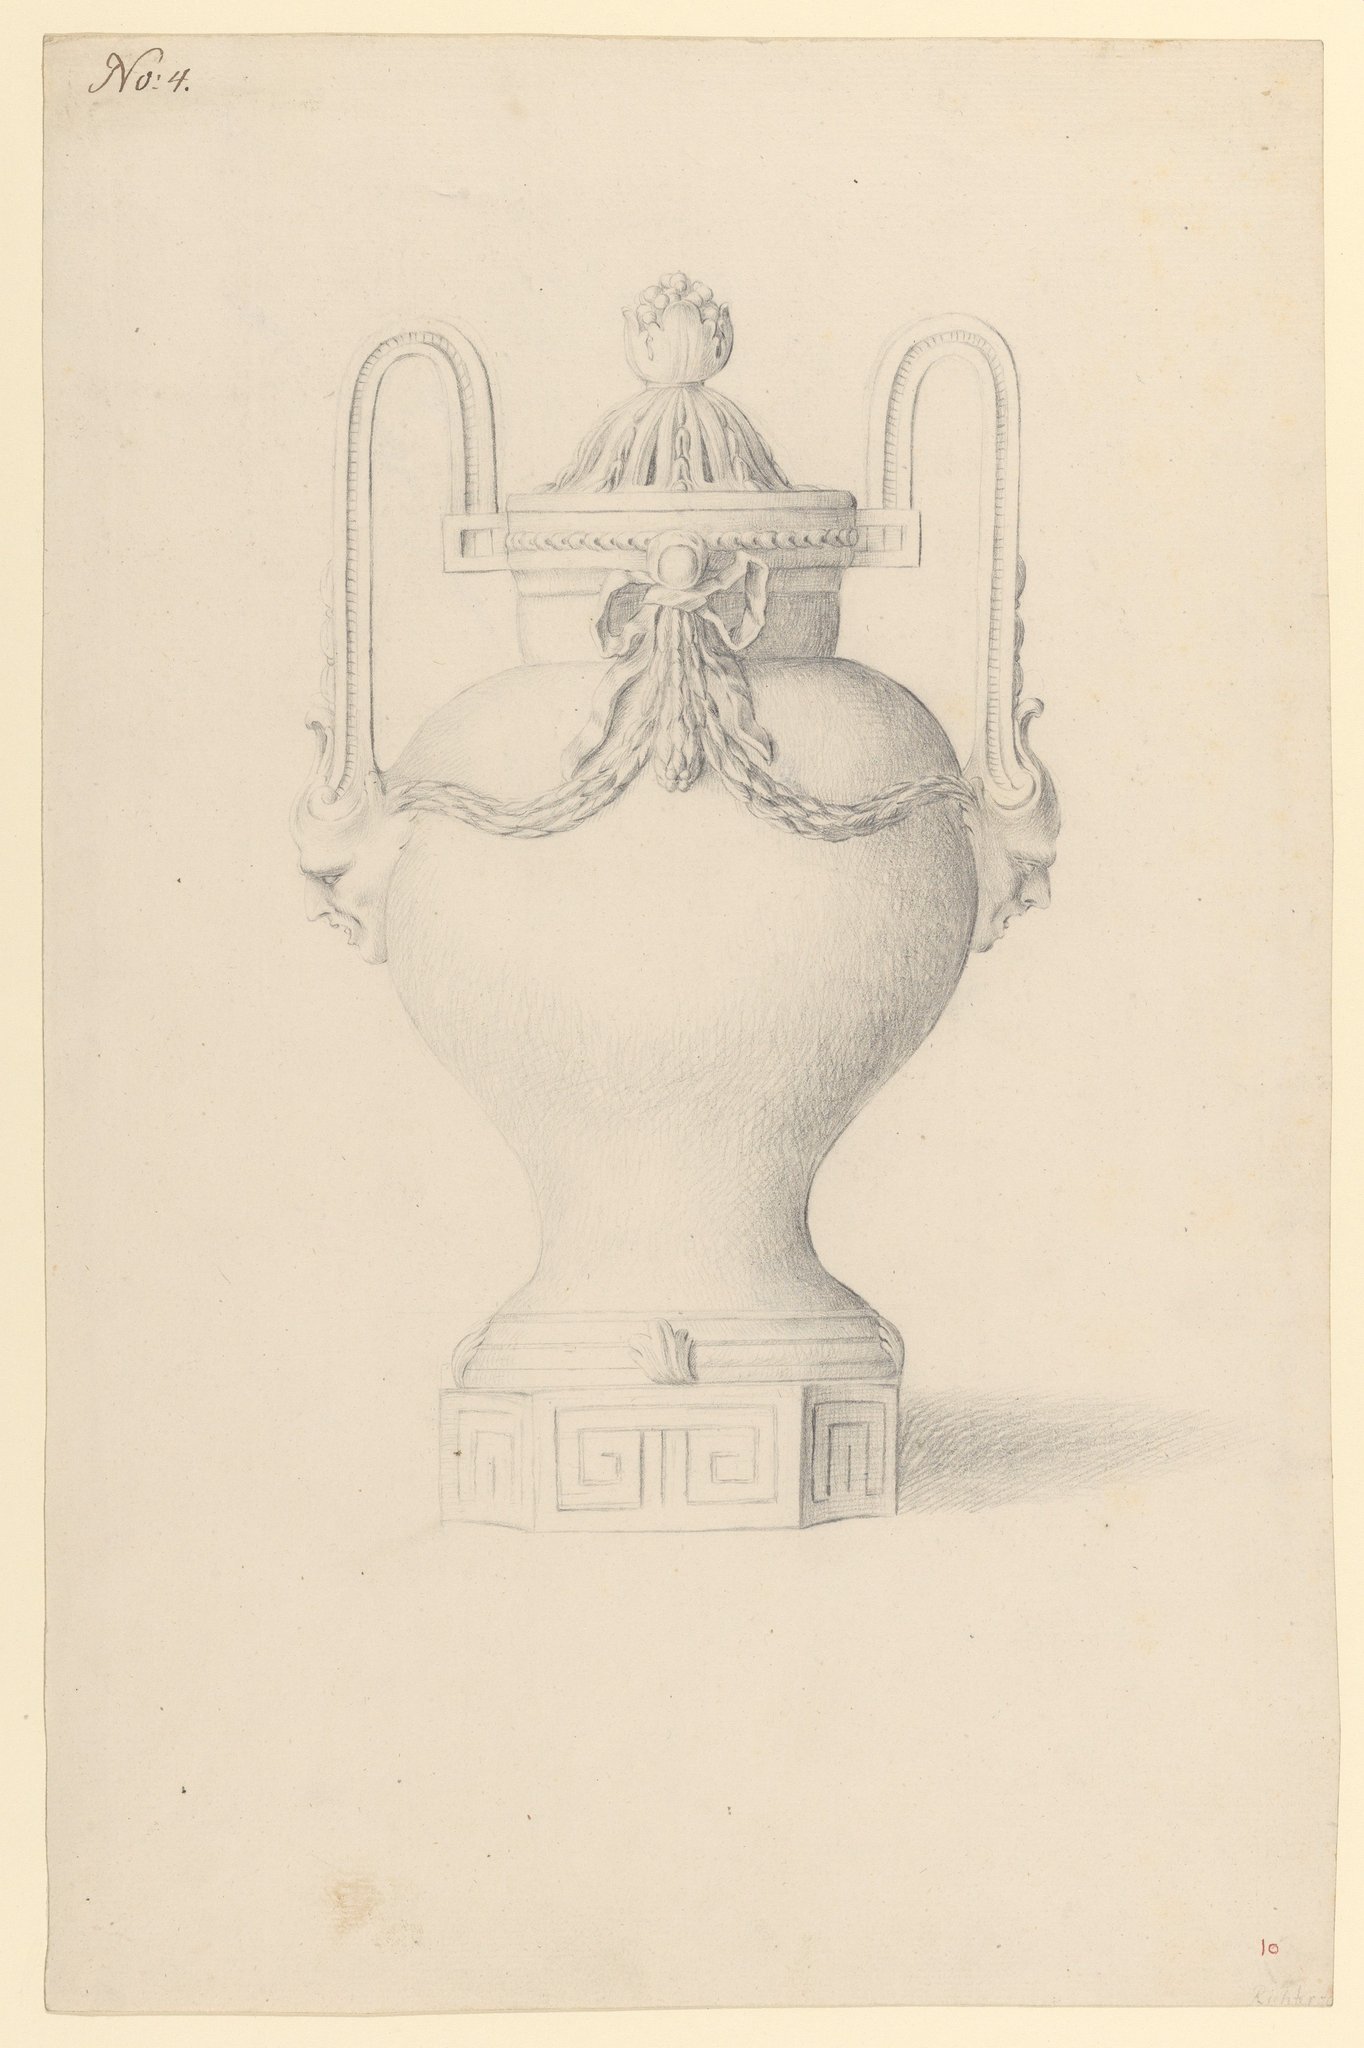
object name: drawing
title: Design for an Urn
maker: anonymous, french, 18th century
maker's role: artist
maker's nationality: french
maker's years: 1700-1800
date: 1770-1790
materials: graphite, ink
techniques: pen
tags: urns